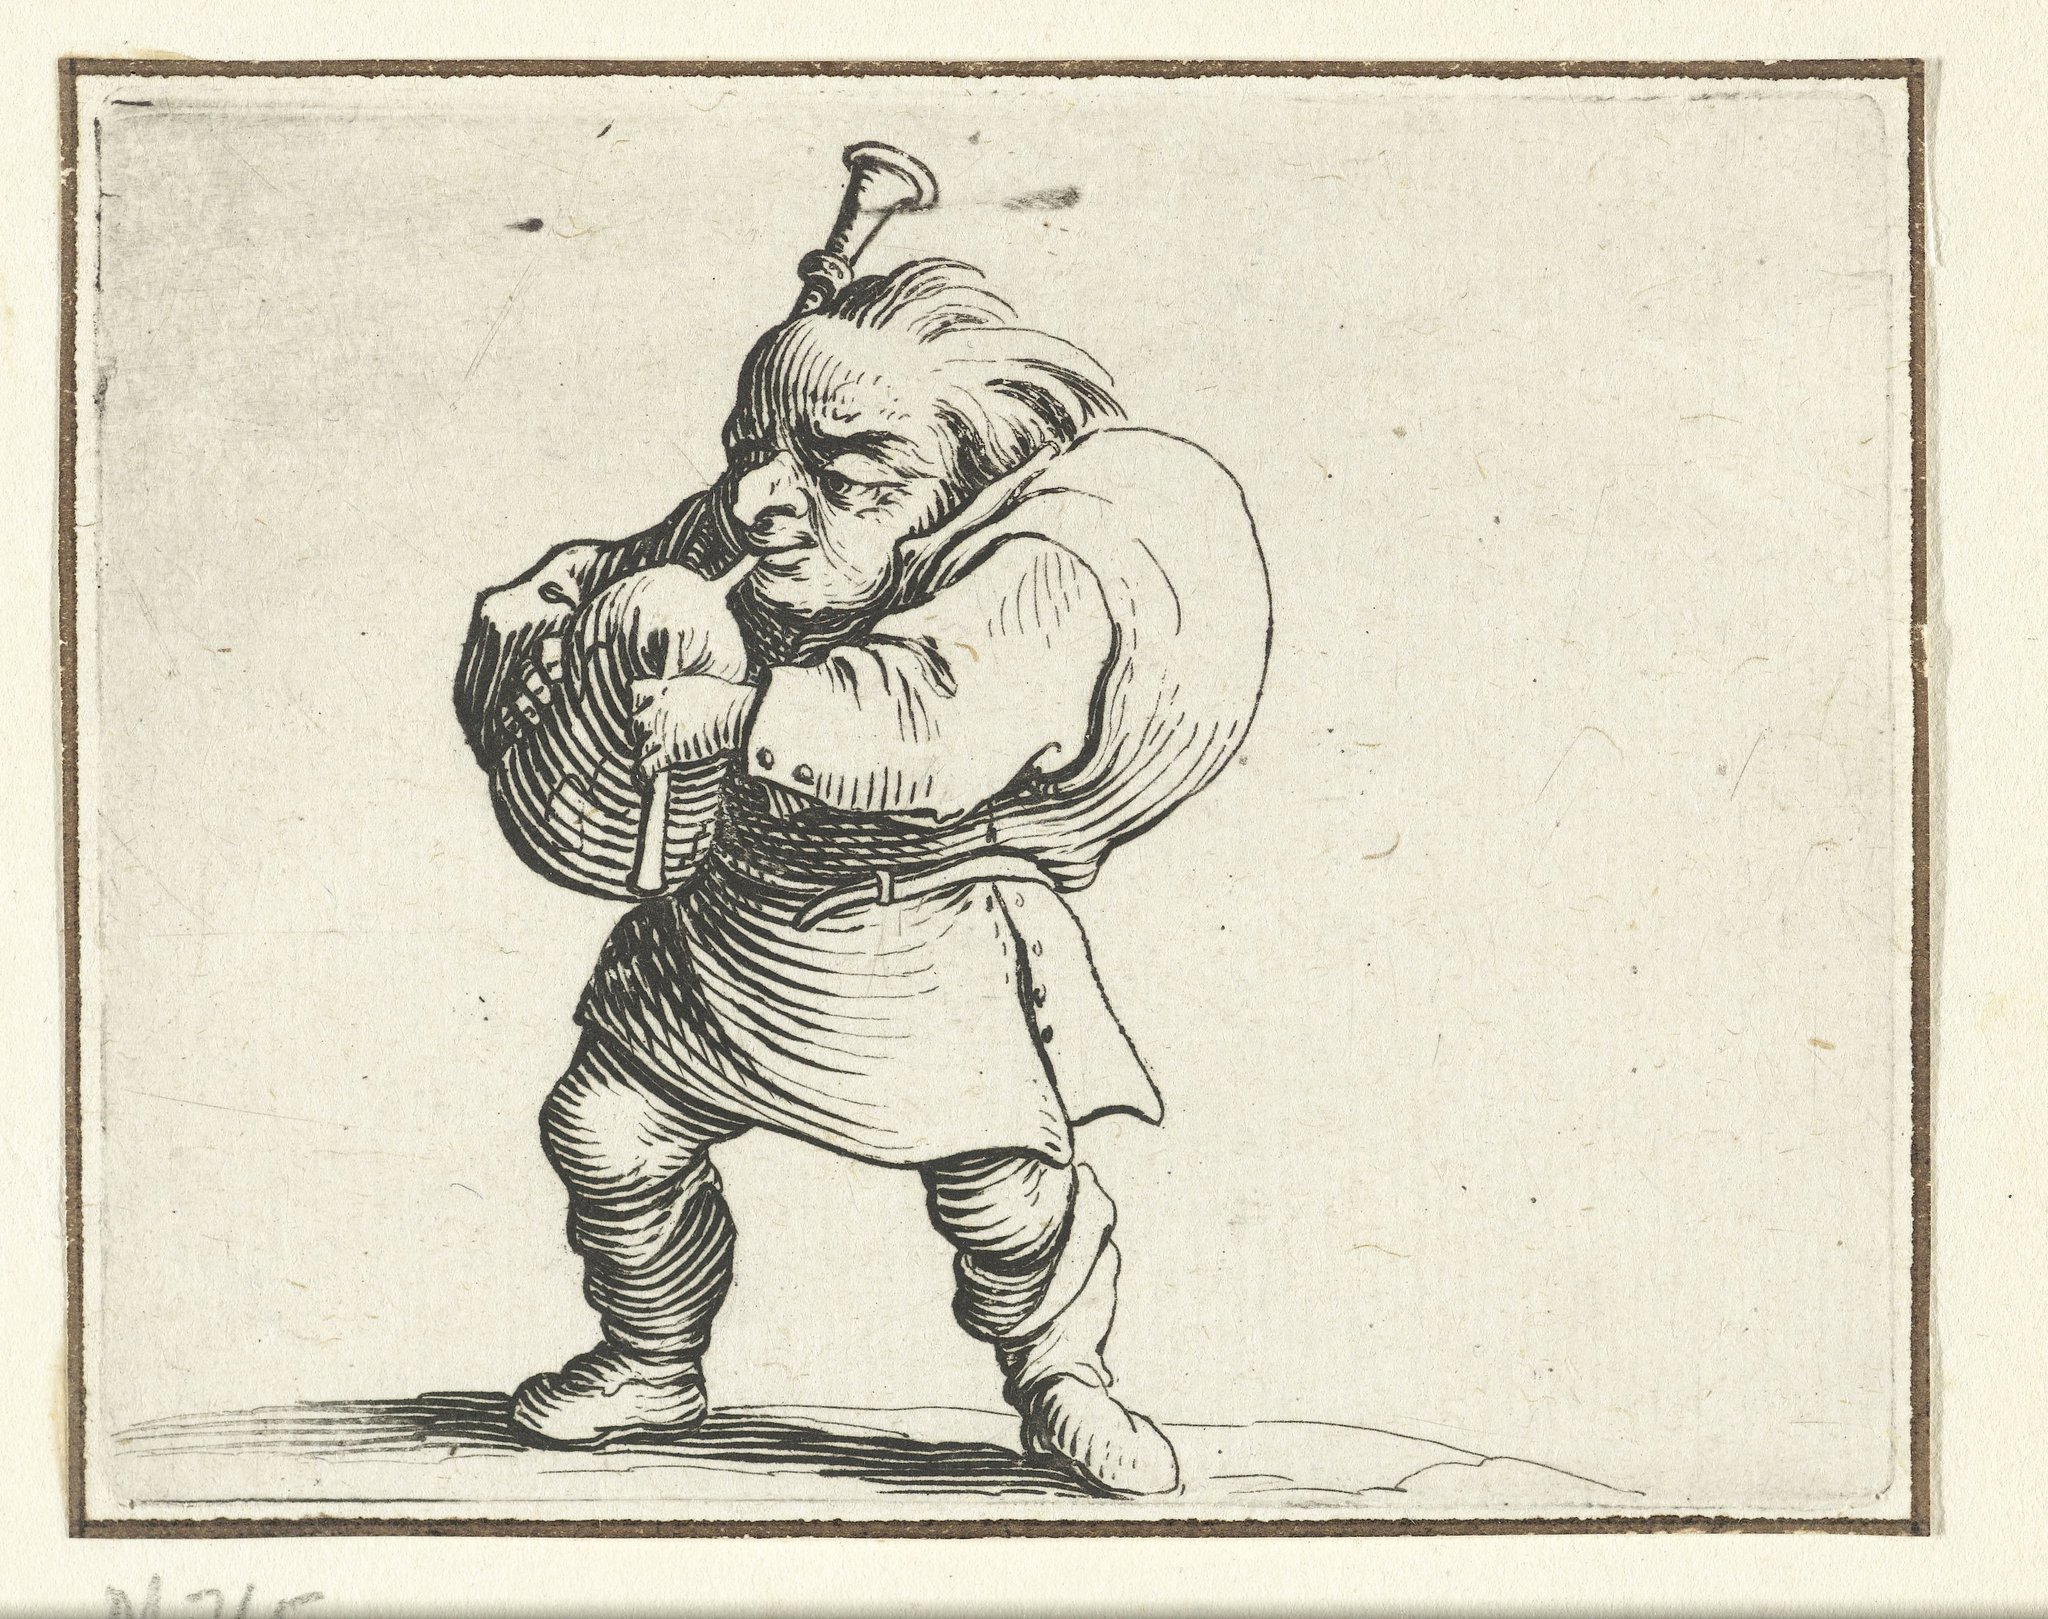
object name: print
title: Varie figure gobbi di Jacopo Callot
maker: jacques callot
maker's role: draughtsman, print maker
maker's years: 1592-1635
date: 1621-1625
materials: paper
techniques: engraving, etching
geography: nancy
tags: one person playing wind instrument, little people, bagpipe, musette, hunchback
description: Een kleine mens (karikatuur), op de linkerzijde gezien, met een gebochelde rug, een doedelzak bespelend. Deze prent is onderdeel van een serie van 21 prenten met groteske figuren; vrijwel al die figuren zijn karikaturen van kleine mensen, velen zijn gebocheld.